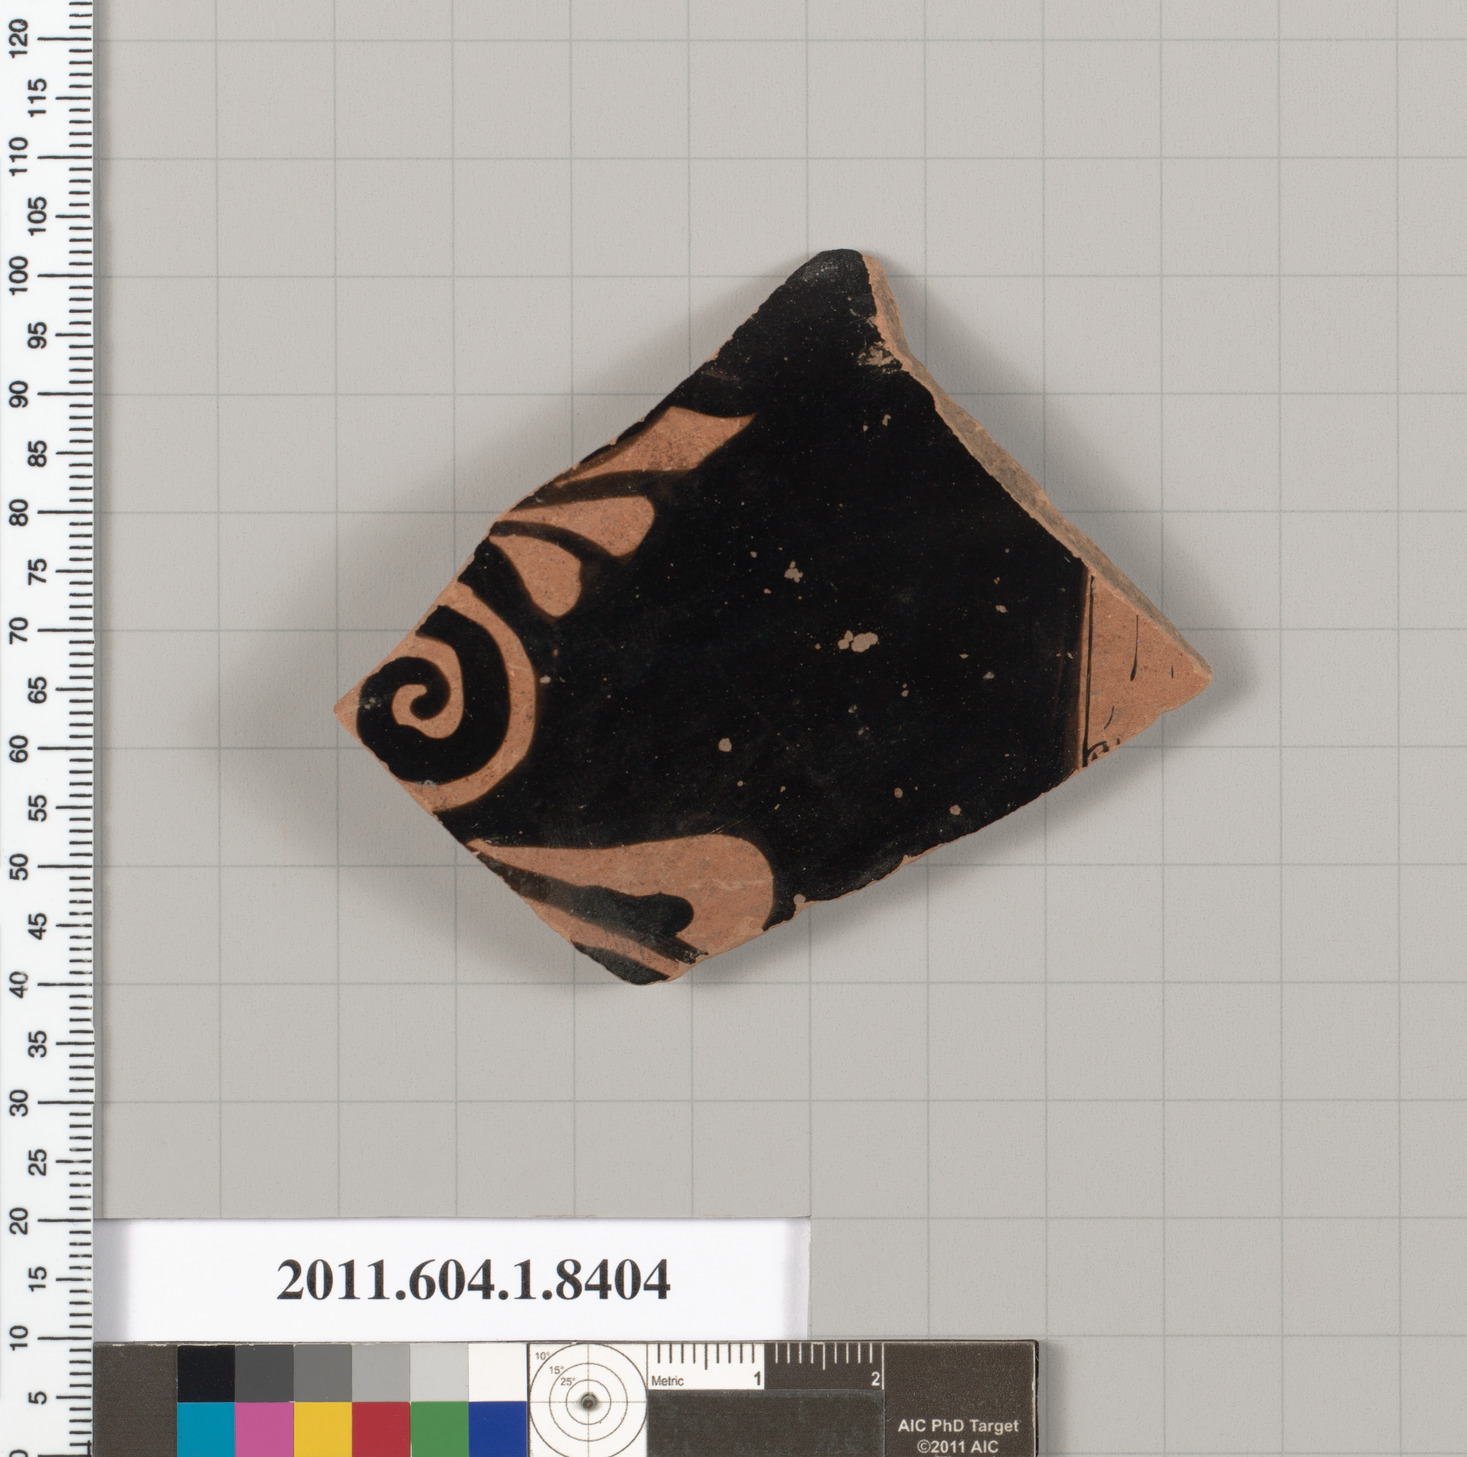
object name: kylix fragment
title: Terracotta fragment of a kylix (drinking cup)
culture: greek, attic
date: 400-351 BCE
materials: terracotta